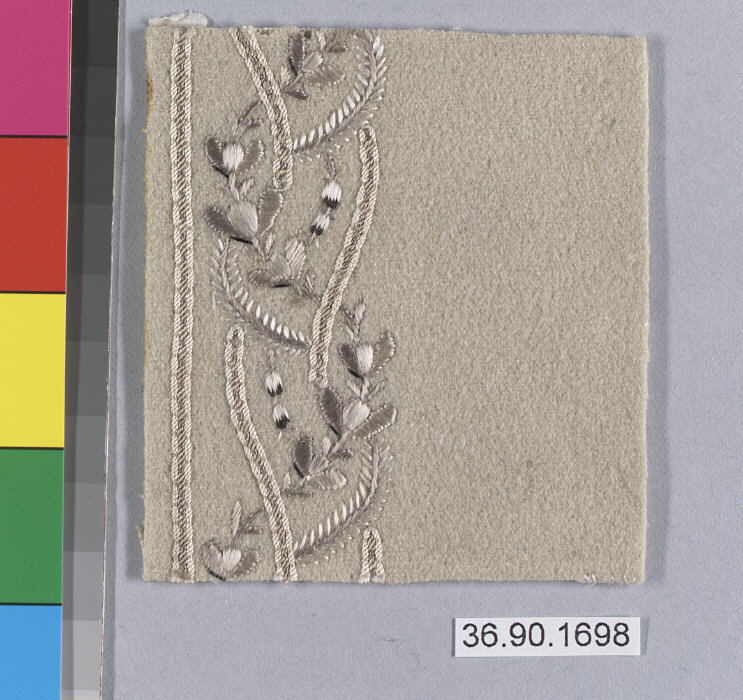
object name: sample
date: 1801-1833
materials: felt, silk